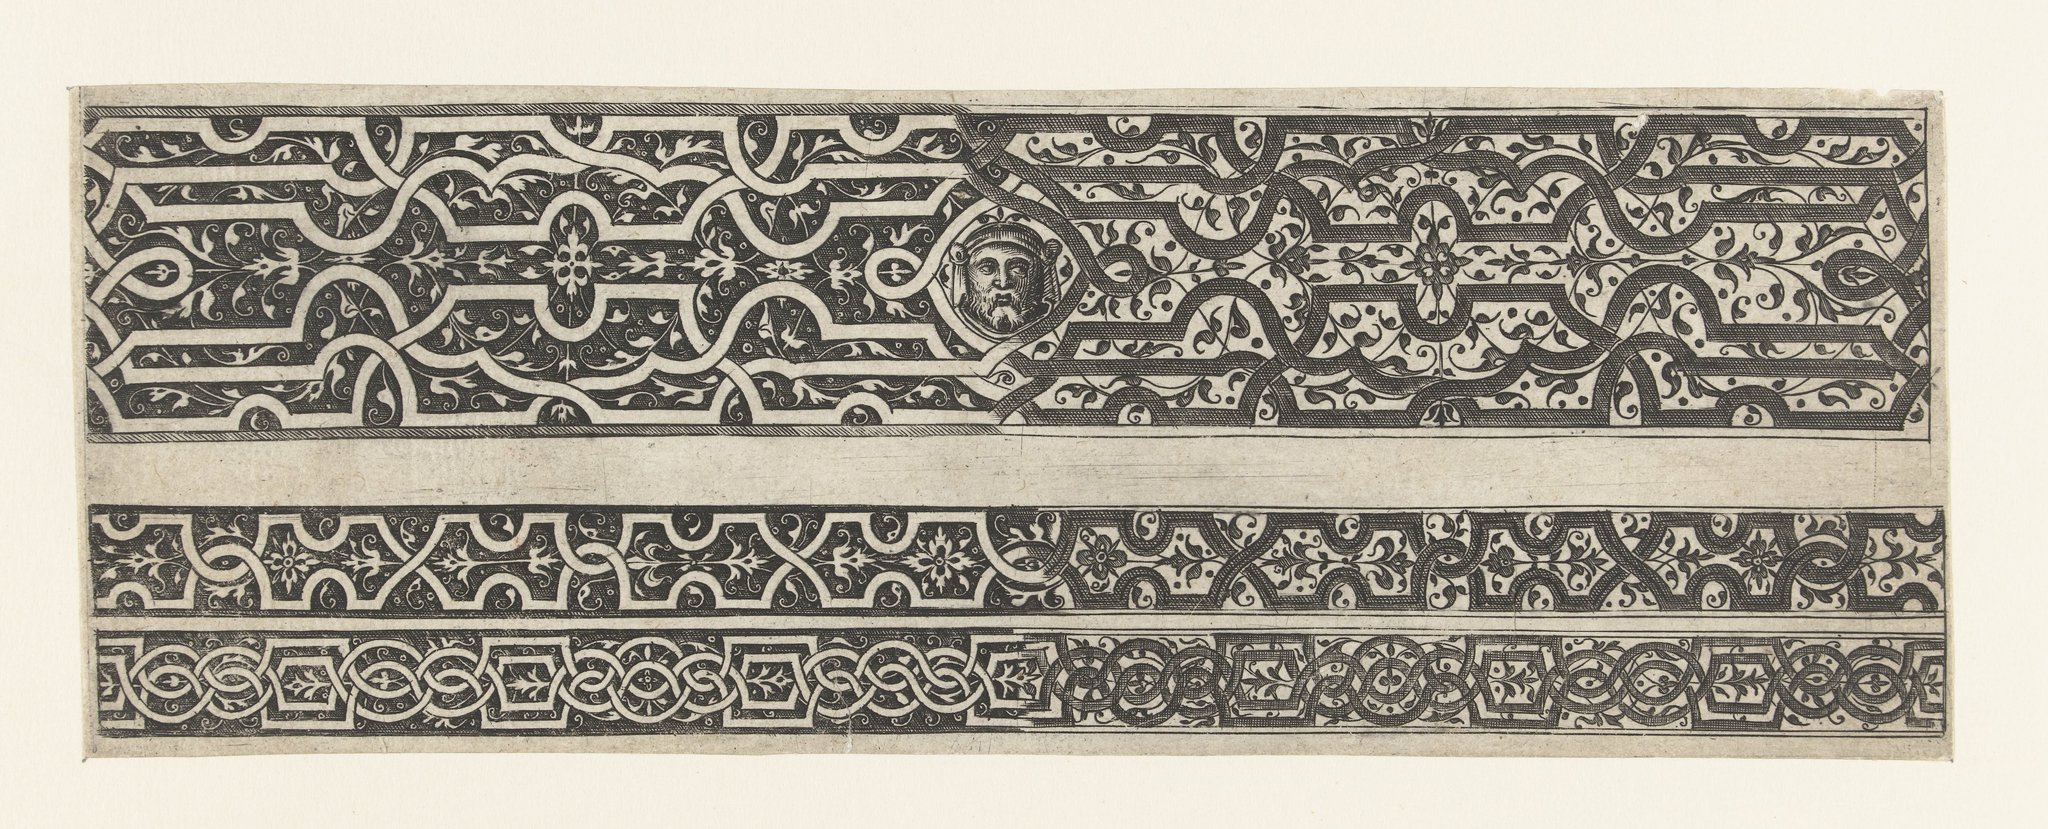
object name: print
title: Eén breed fries en twee smalle friezen met moresken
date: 1550-1580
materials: paper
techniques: engraving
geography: netherlands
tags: ornament ~ moresque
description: De linker helft van de friezen bestaat uit witte moresken op een donker fond, de rechter helft uit zwarte moresken op een witte ondergrond. In het midden van het brede fries bevindt zich een mascaron. Een van 15 bladen afkomstig uit een serie van 23 met titelblad.